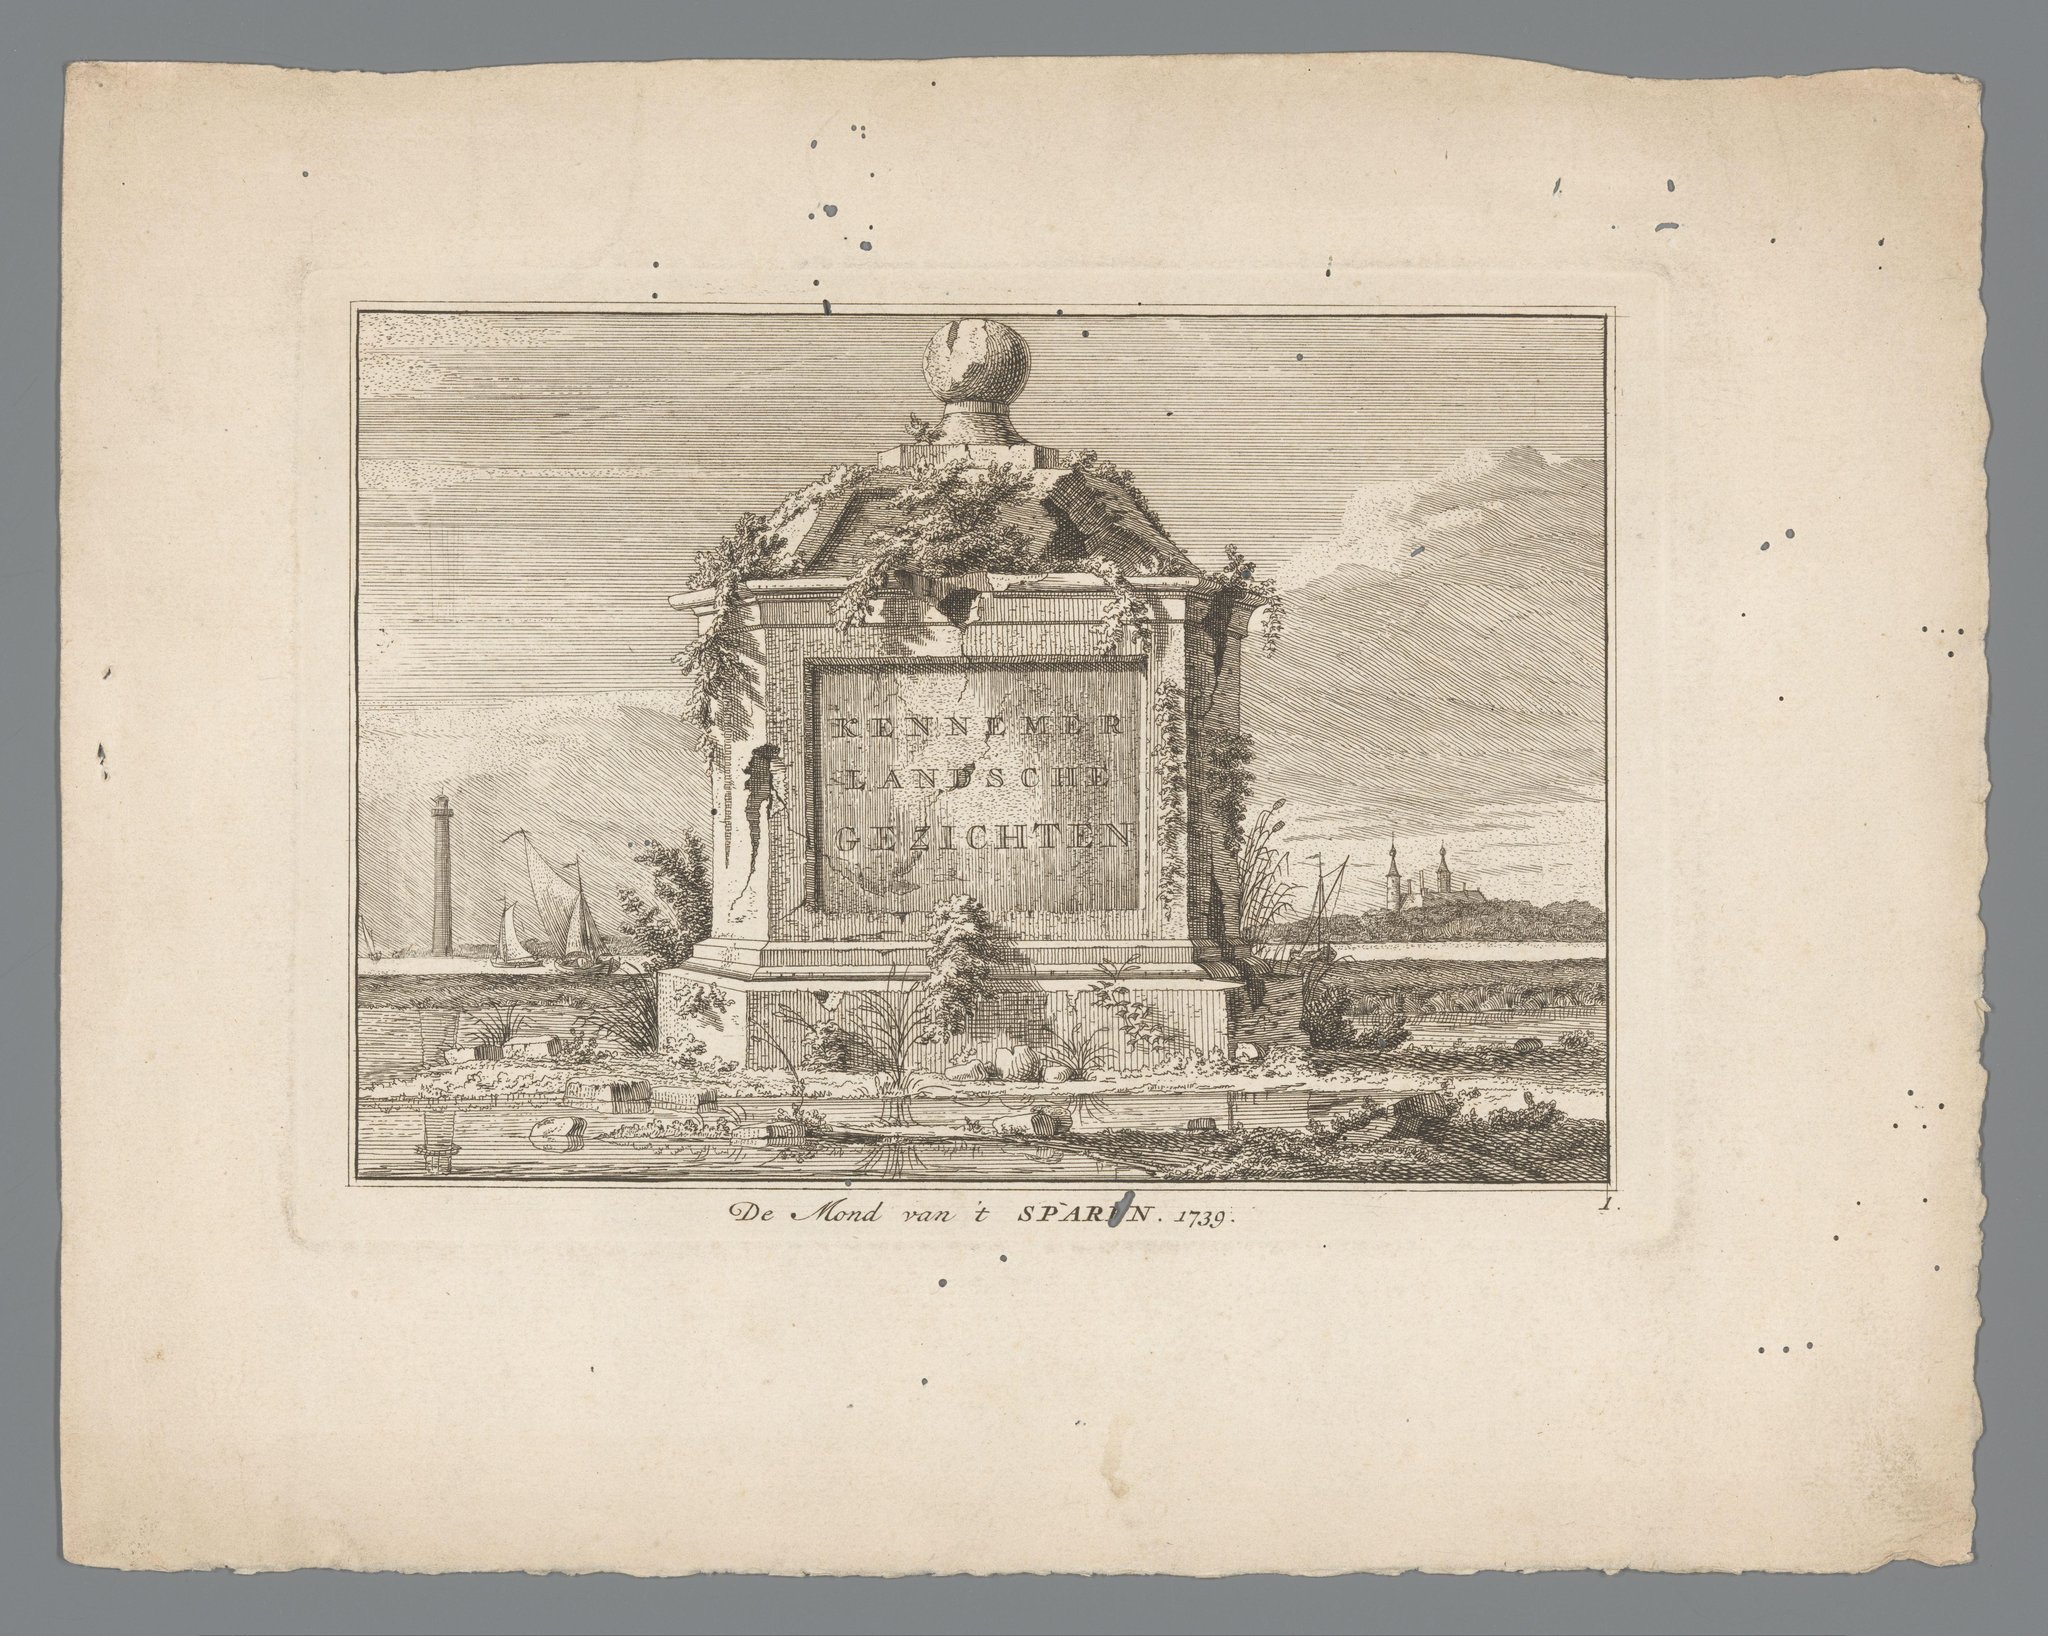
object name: print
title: De Mond van 't Sparen. 1739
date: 1739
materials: paper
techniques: etching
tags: landscape with monument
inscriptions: collector's mark: Lugt 2228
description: Prent uit: Kennemerlandsche Gezichten. S.l.s.n., 1739. Sommige latere uitgaven van deze serie hebben het adres van Pierre Fouquet in Amsterdam.